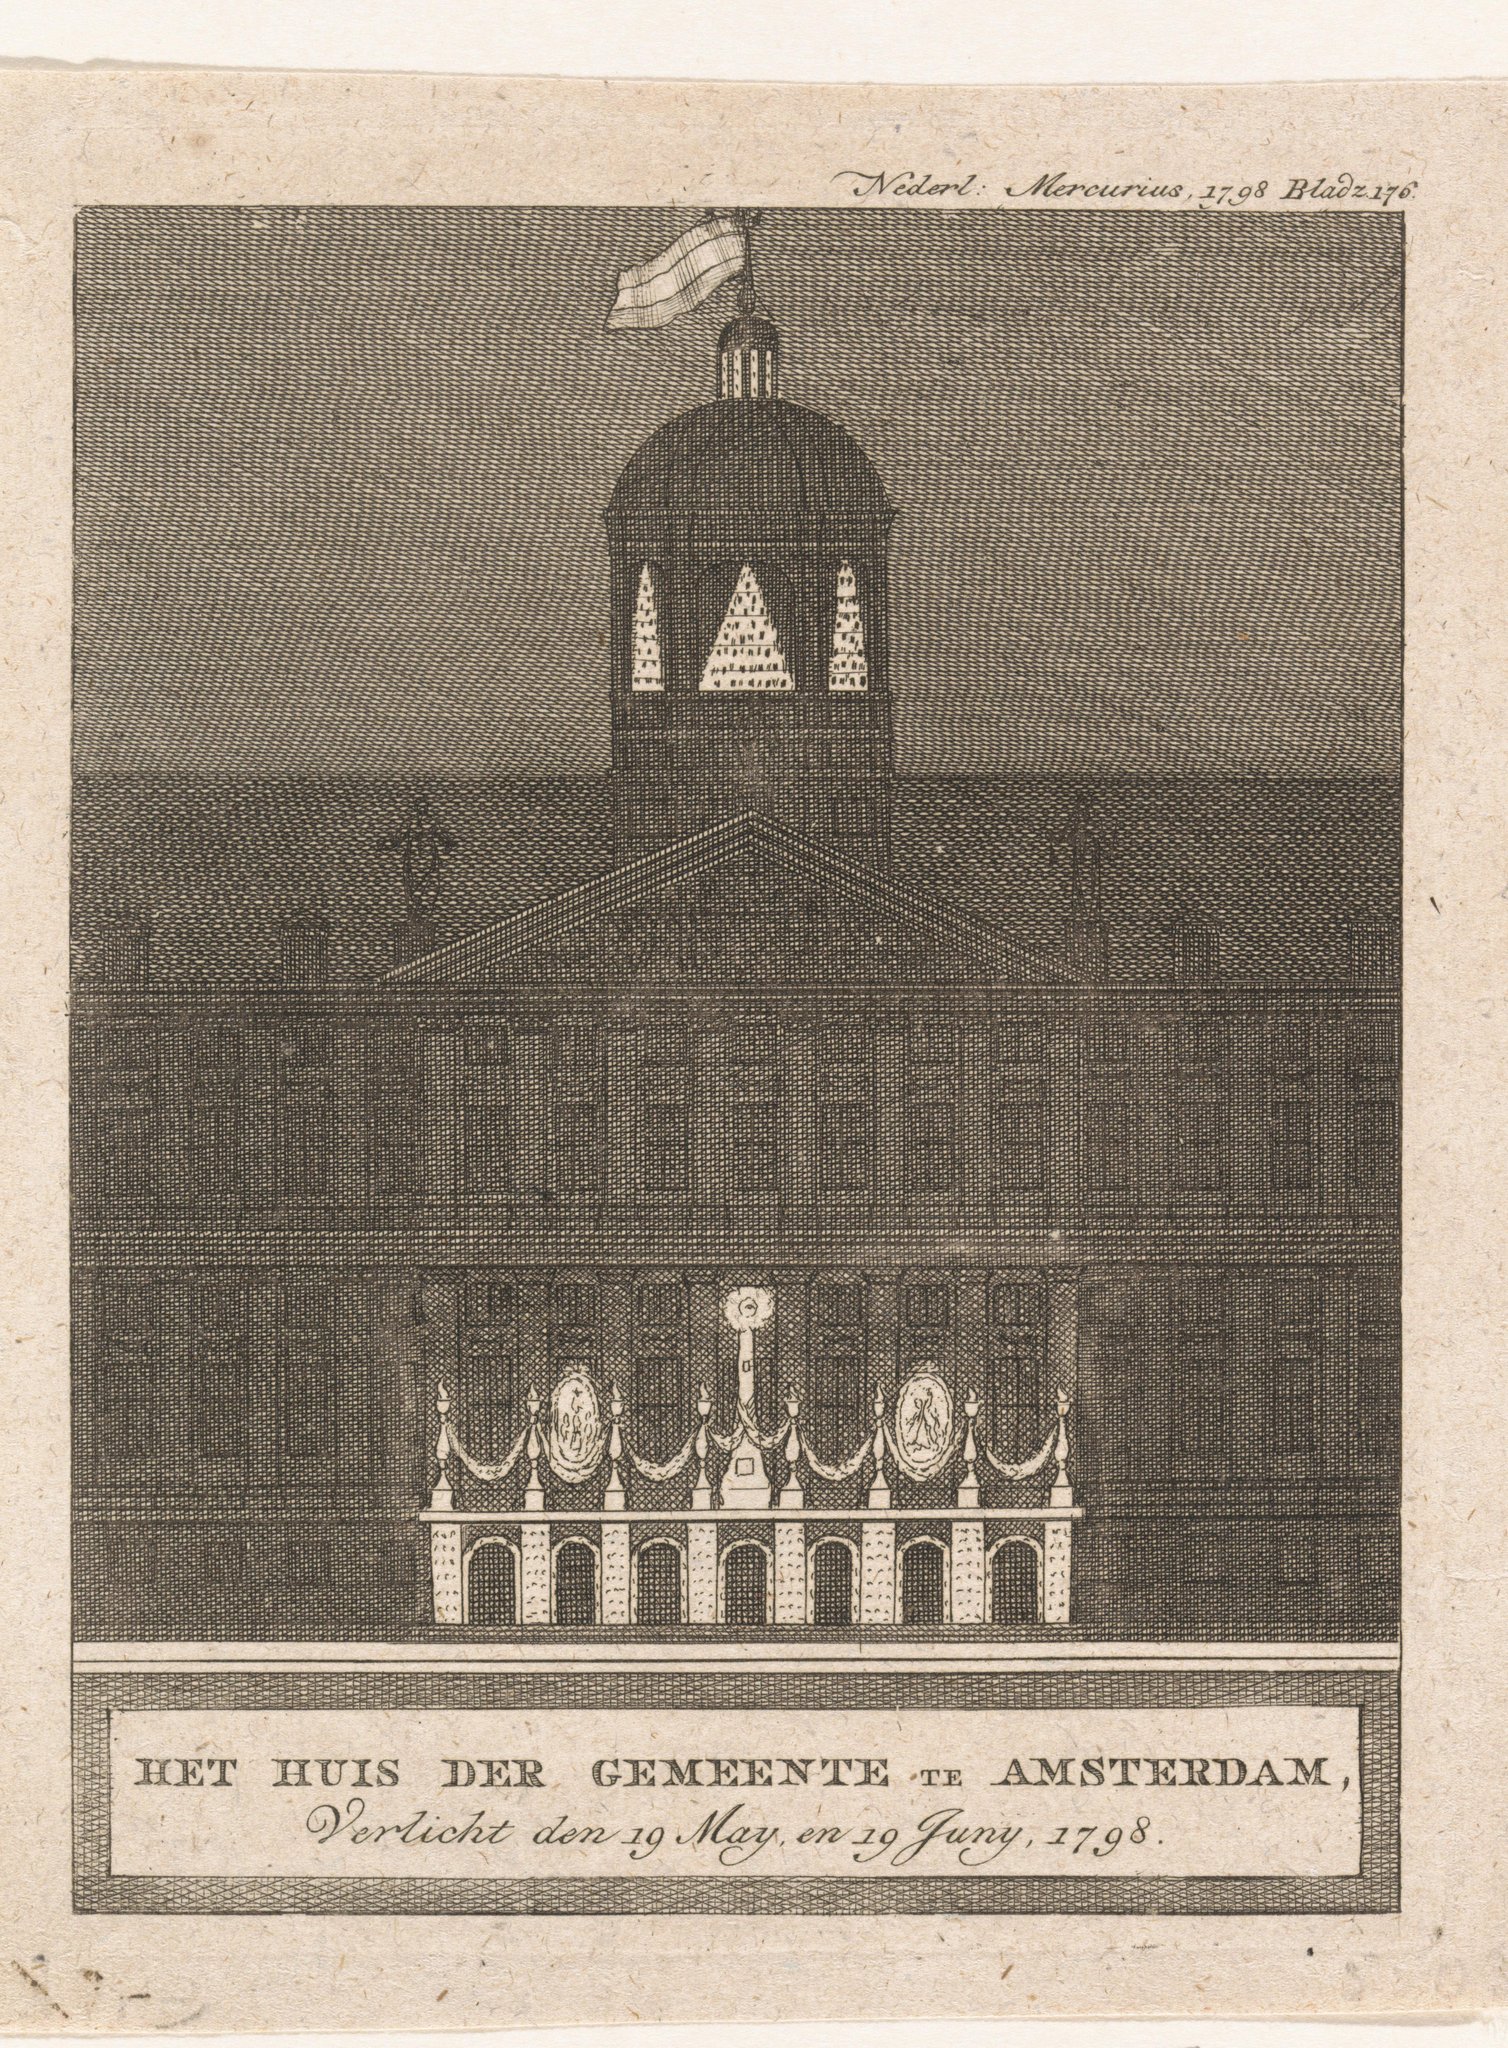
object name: print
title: Het Huis der Gemeente te Amsterdam, Verlicht den 19 May en 19 Juny, 1798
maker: Anonymous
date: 1798-1799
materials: paper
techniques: engraving, etching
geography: netherlands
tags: bonfire, fire-works (+ illumination, fire-works ~ festive activities)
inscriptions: collector's mark: Lugt 2228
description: Illuminatie van het Amsterdamse Stadhuis op de Dam, 19 mei en 19 juni 1798. Ter viering van de aanneming van de Staatsregeling op 19 mei 1798.